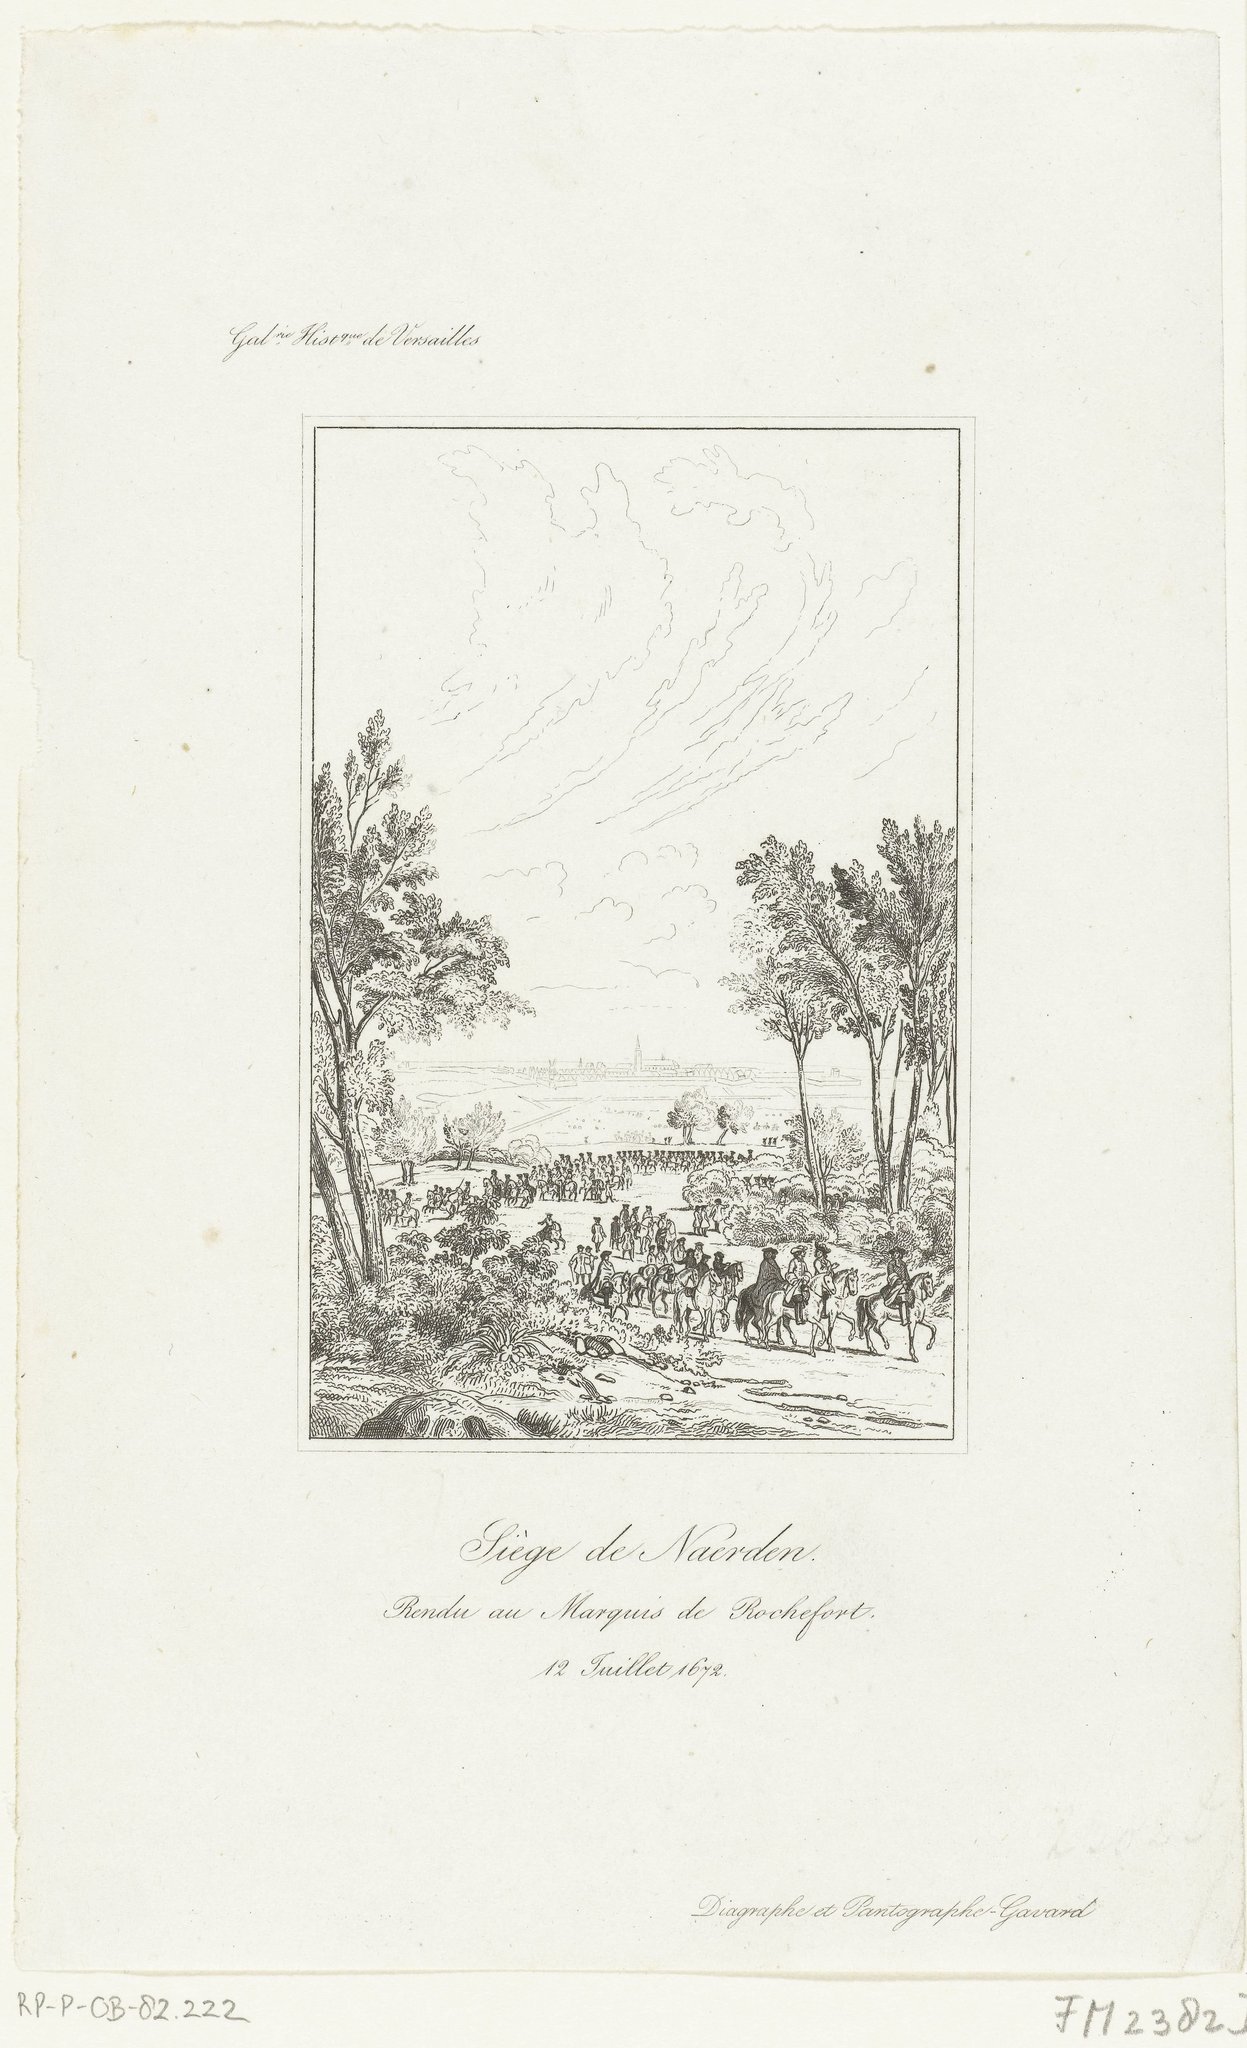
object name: history print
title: Beleg van Naarden, 1672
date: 1835-1840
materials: paper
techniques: etching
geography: france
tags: lodewijk xiv (koning van frankrijk), capture of city (after the siege), rampjaar (disaster year)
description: Gebruikt als illustratie in: C. Gavard, Galeries historiques de Versailles, collection de gravures réduites d'après les dessins originaux du grand ouvrage, Parijs 1840. Niet in Frederik Muller; door het RPK toegevoegd nummer. Op de prent vermeld: Diagraphe et Pantographe Gavard.